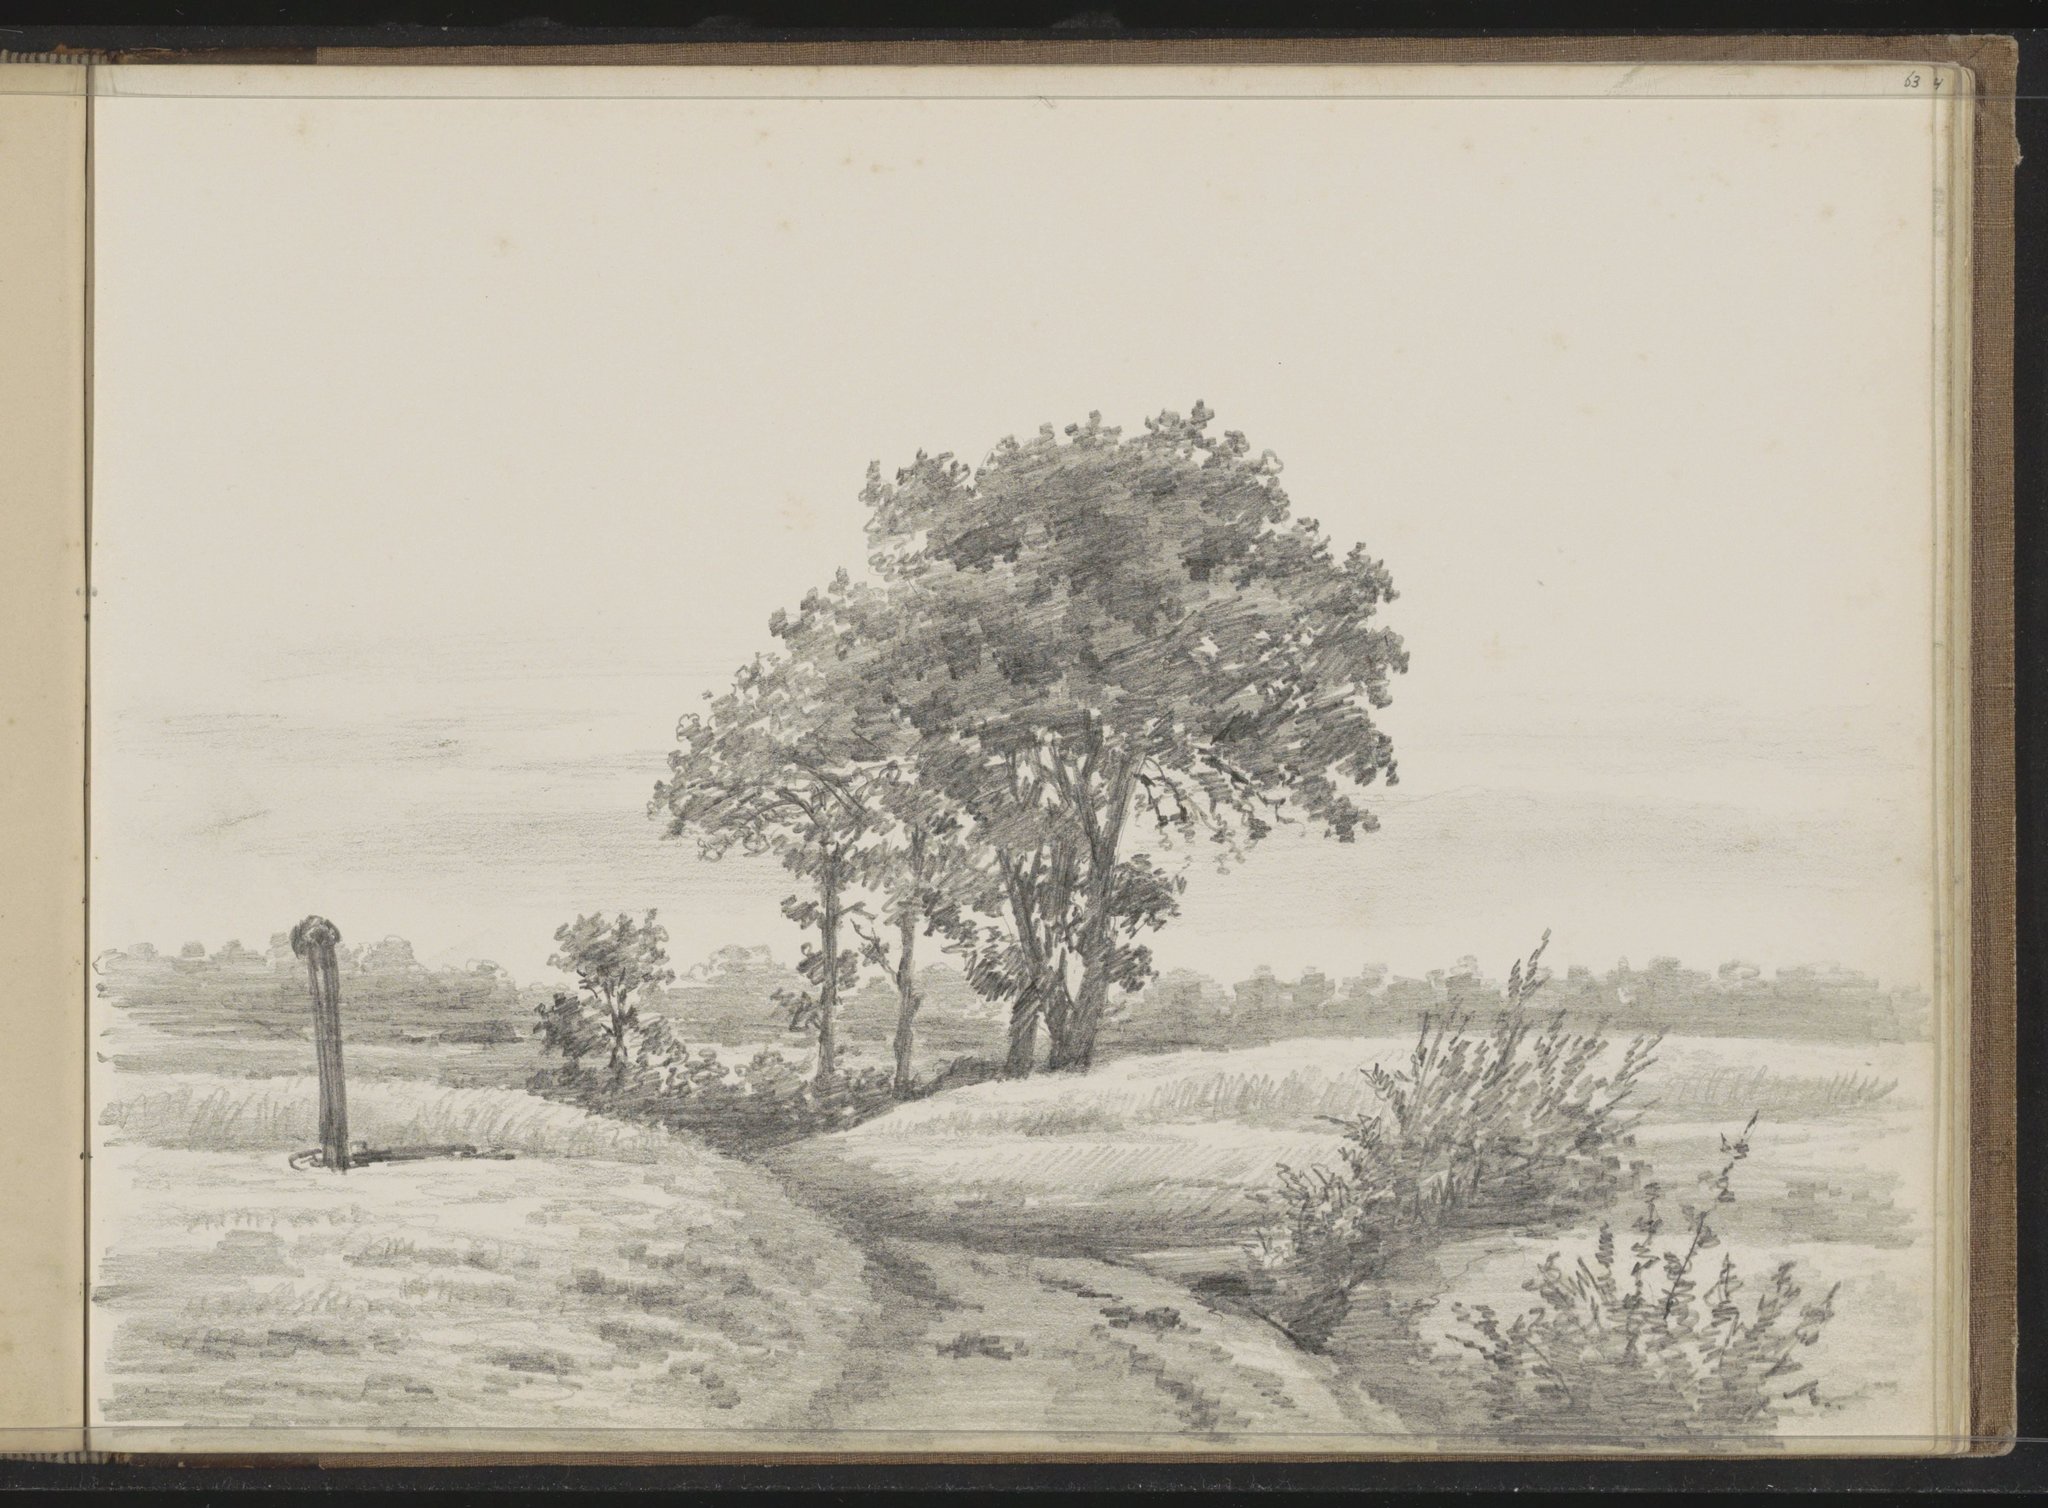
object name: sketchbook leaf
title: Landschap met bomen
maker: hendrik valkenburg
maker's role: draughtsman, painter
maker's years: 1826-1896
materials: paper, pencil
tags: trees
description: Blad 63 recto uit een schetsboek met 77 bladen.